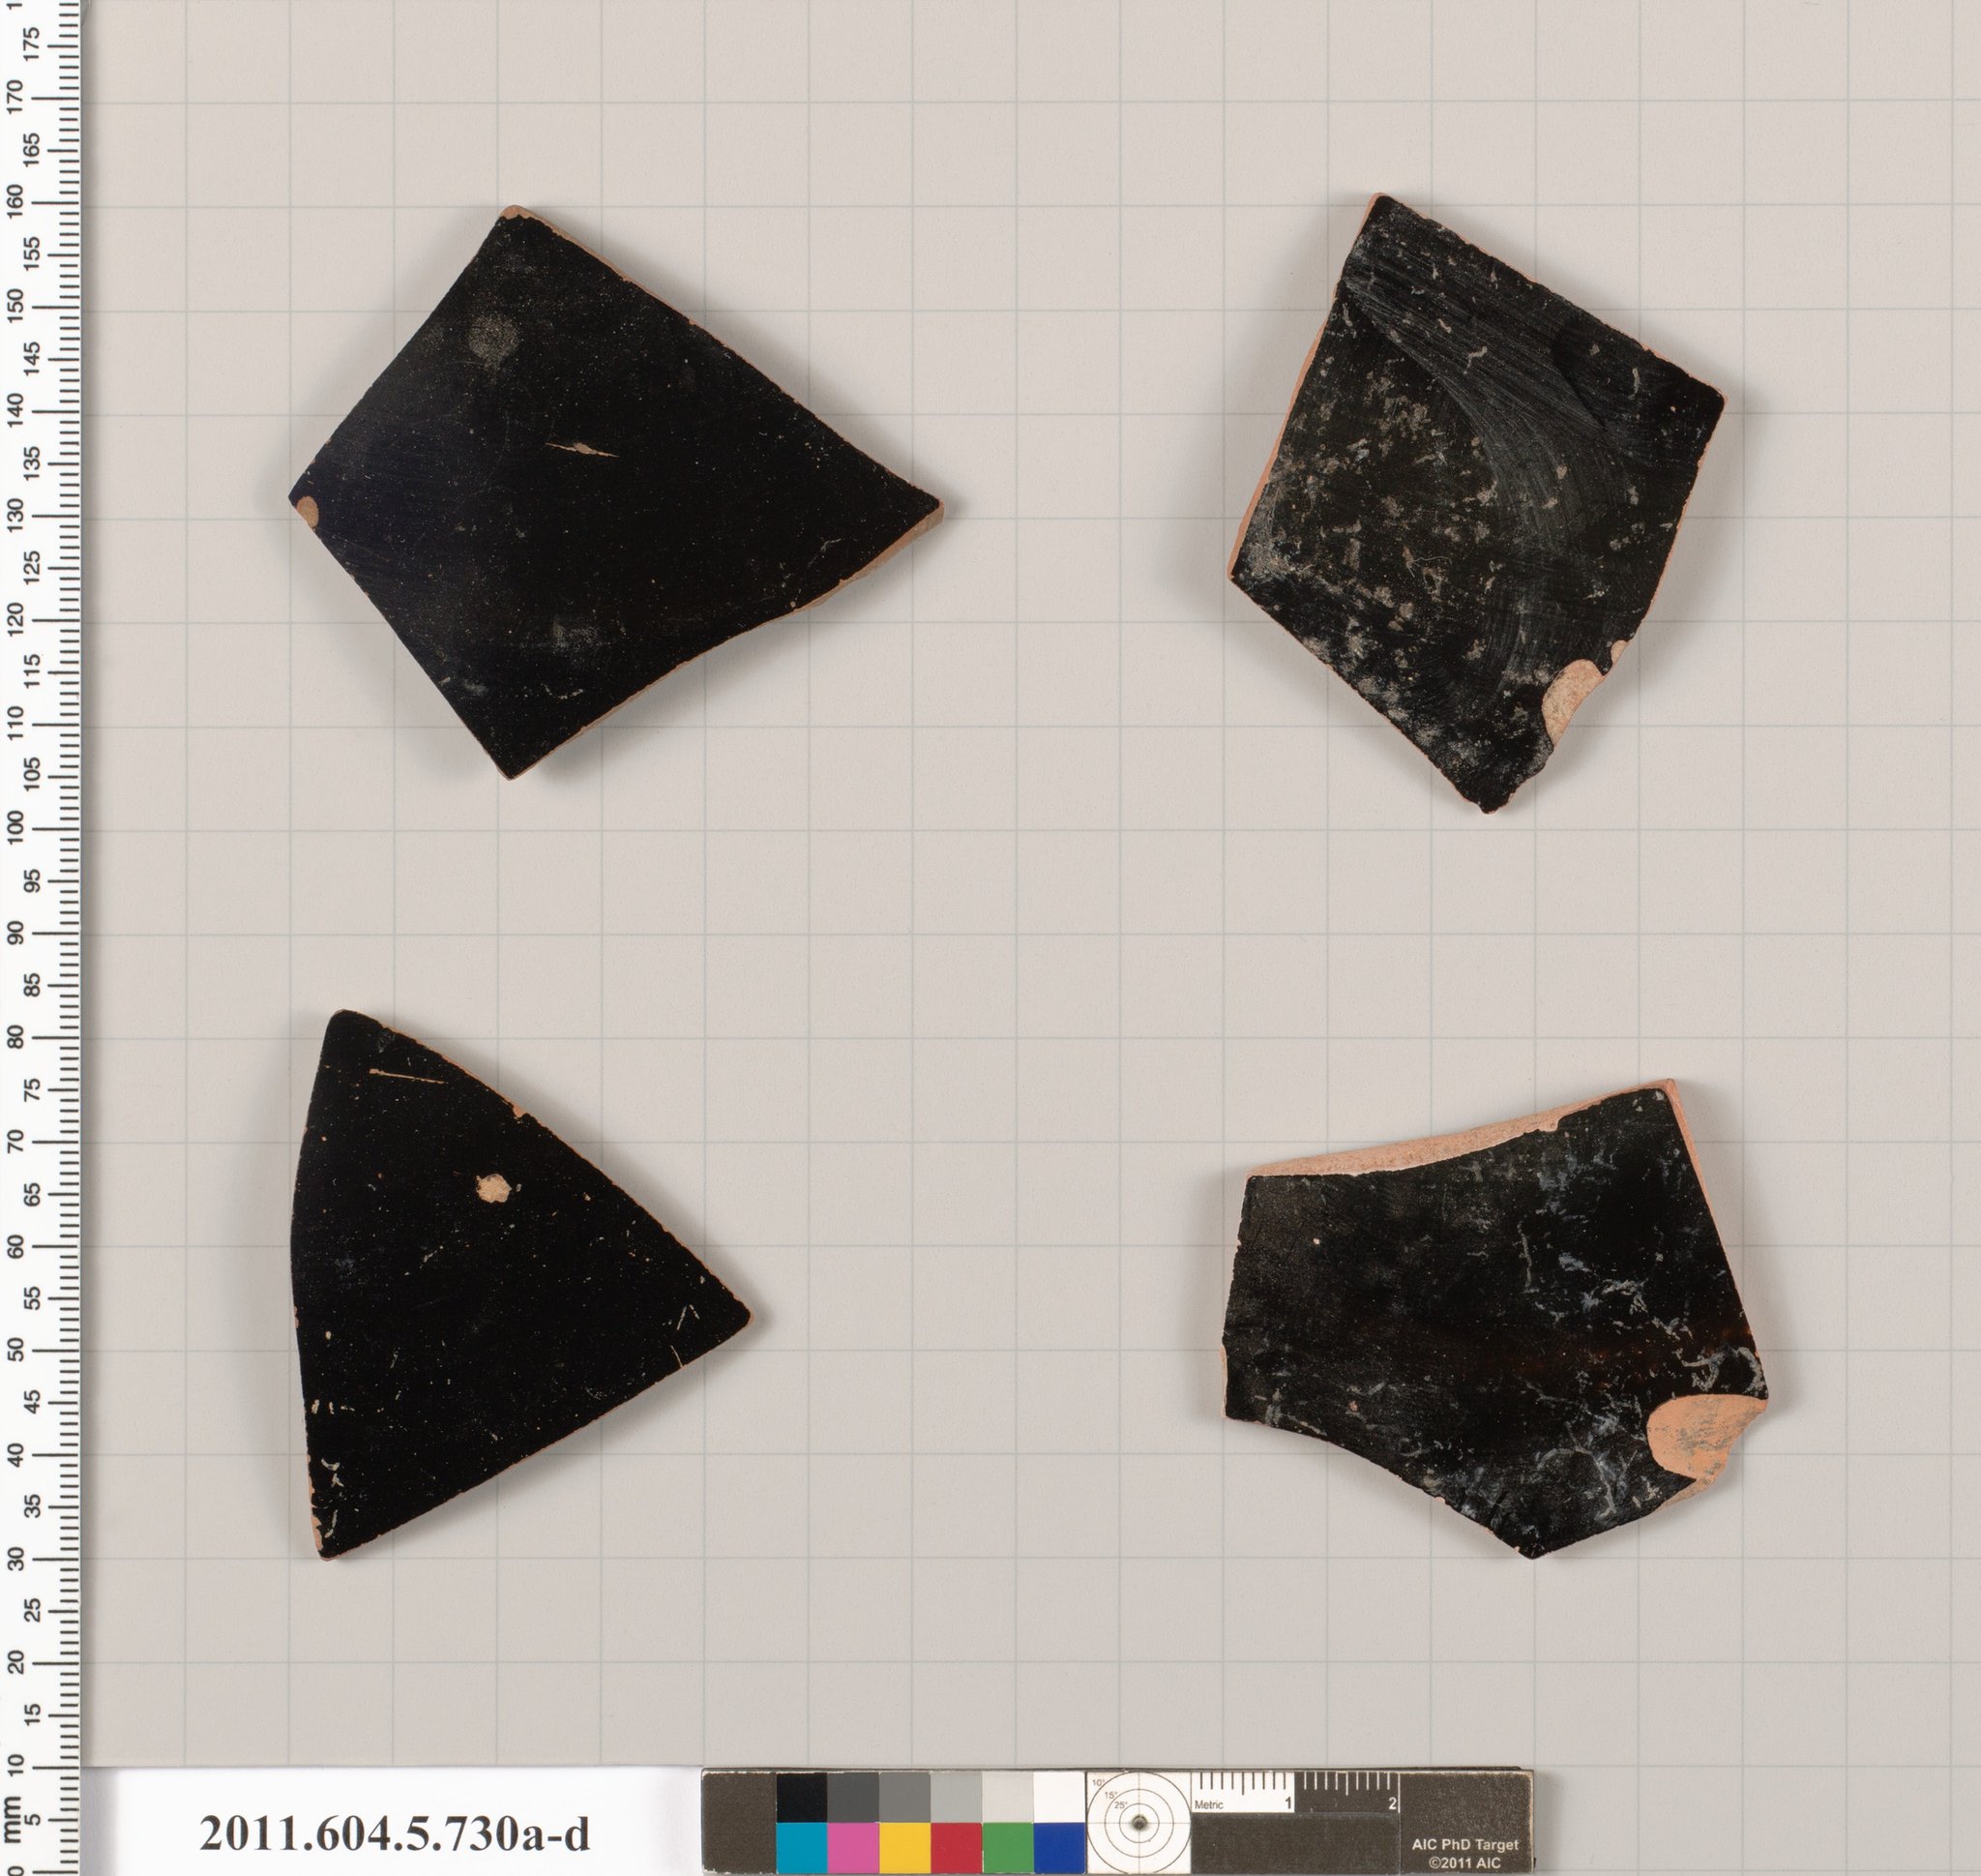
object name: kylix fragment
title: Terracotta fragments of kylikes (drinking cups)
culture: greek, attic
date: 600-401 BCE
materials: terracotta